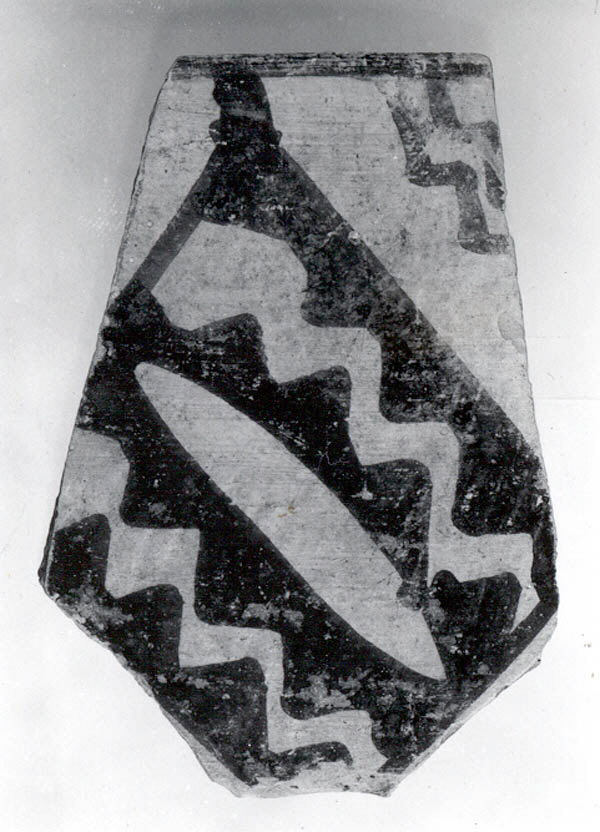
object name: vessel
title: Vessel fragment with painted decoration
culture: indus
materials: ceramic, paint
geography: indus region